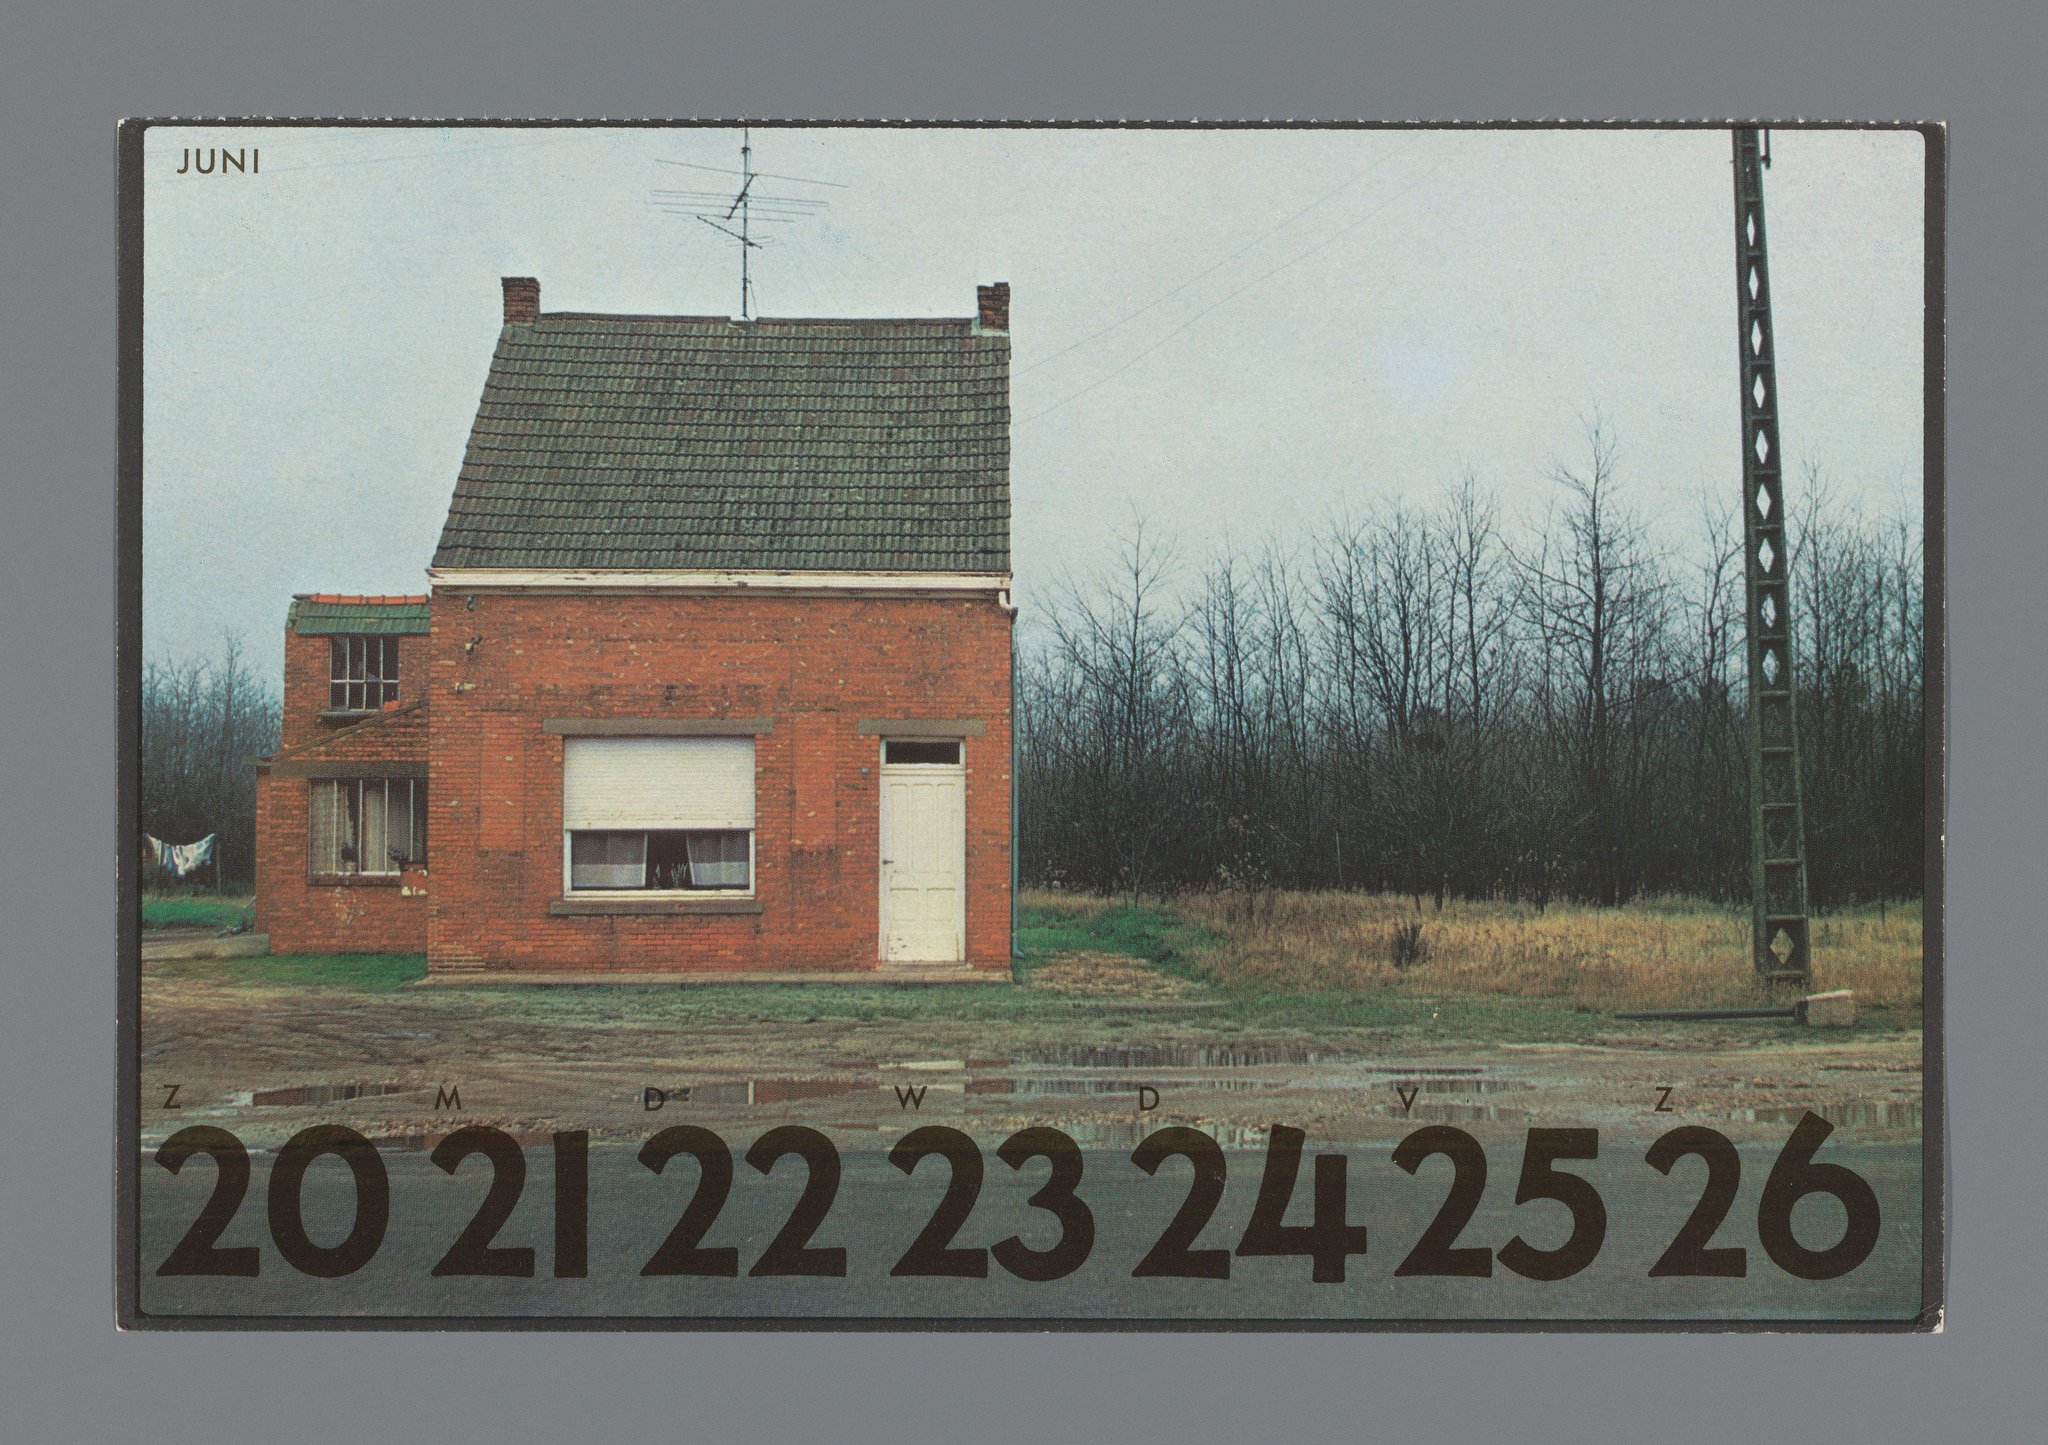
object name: photograph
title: België. Huizen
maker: Anonymous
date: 1900-1950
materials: paper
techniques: offset printed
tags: belgium